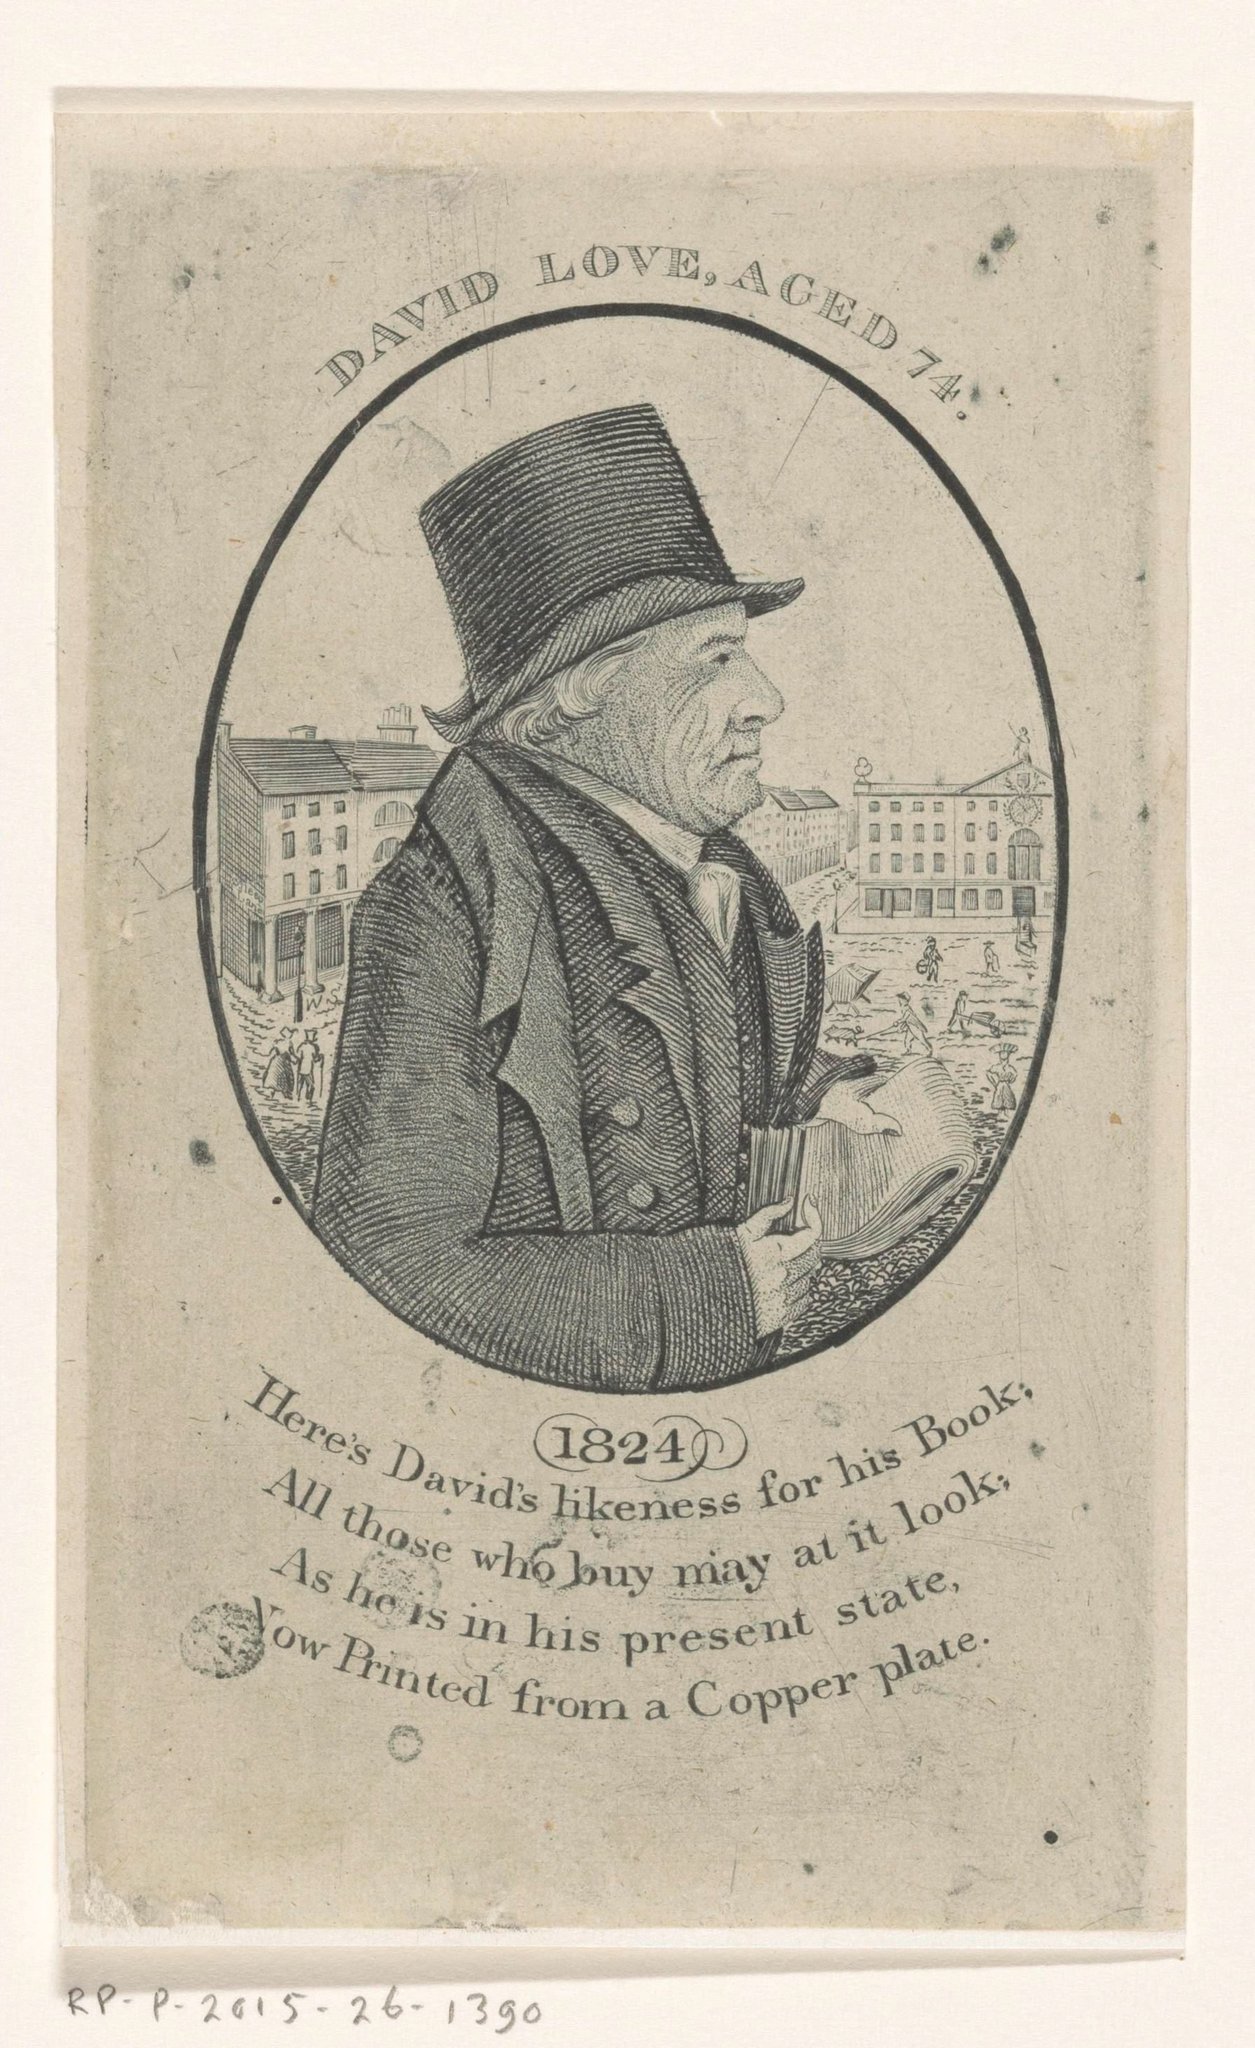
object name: print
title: David Love, aged 74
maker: monogrammist ws (graveur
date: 1824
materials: paper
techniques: engraving, etching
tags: bookseller, street-trader, ballad singer, ballad seller - cc - out of doors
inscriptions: collector's mark: Lugt 2228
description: Portret van David Love, liedzanger en rondreizende lied- en boekverkoper in de omgeving van Nottingham. In zijn handen houdt hij waarschijnlijk een bundel liederen. In de achtergrond een gezicht op het marktplein van Nottingham met de Nottingham Exchange. Met vierregelig onderschrift in het Engels.